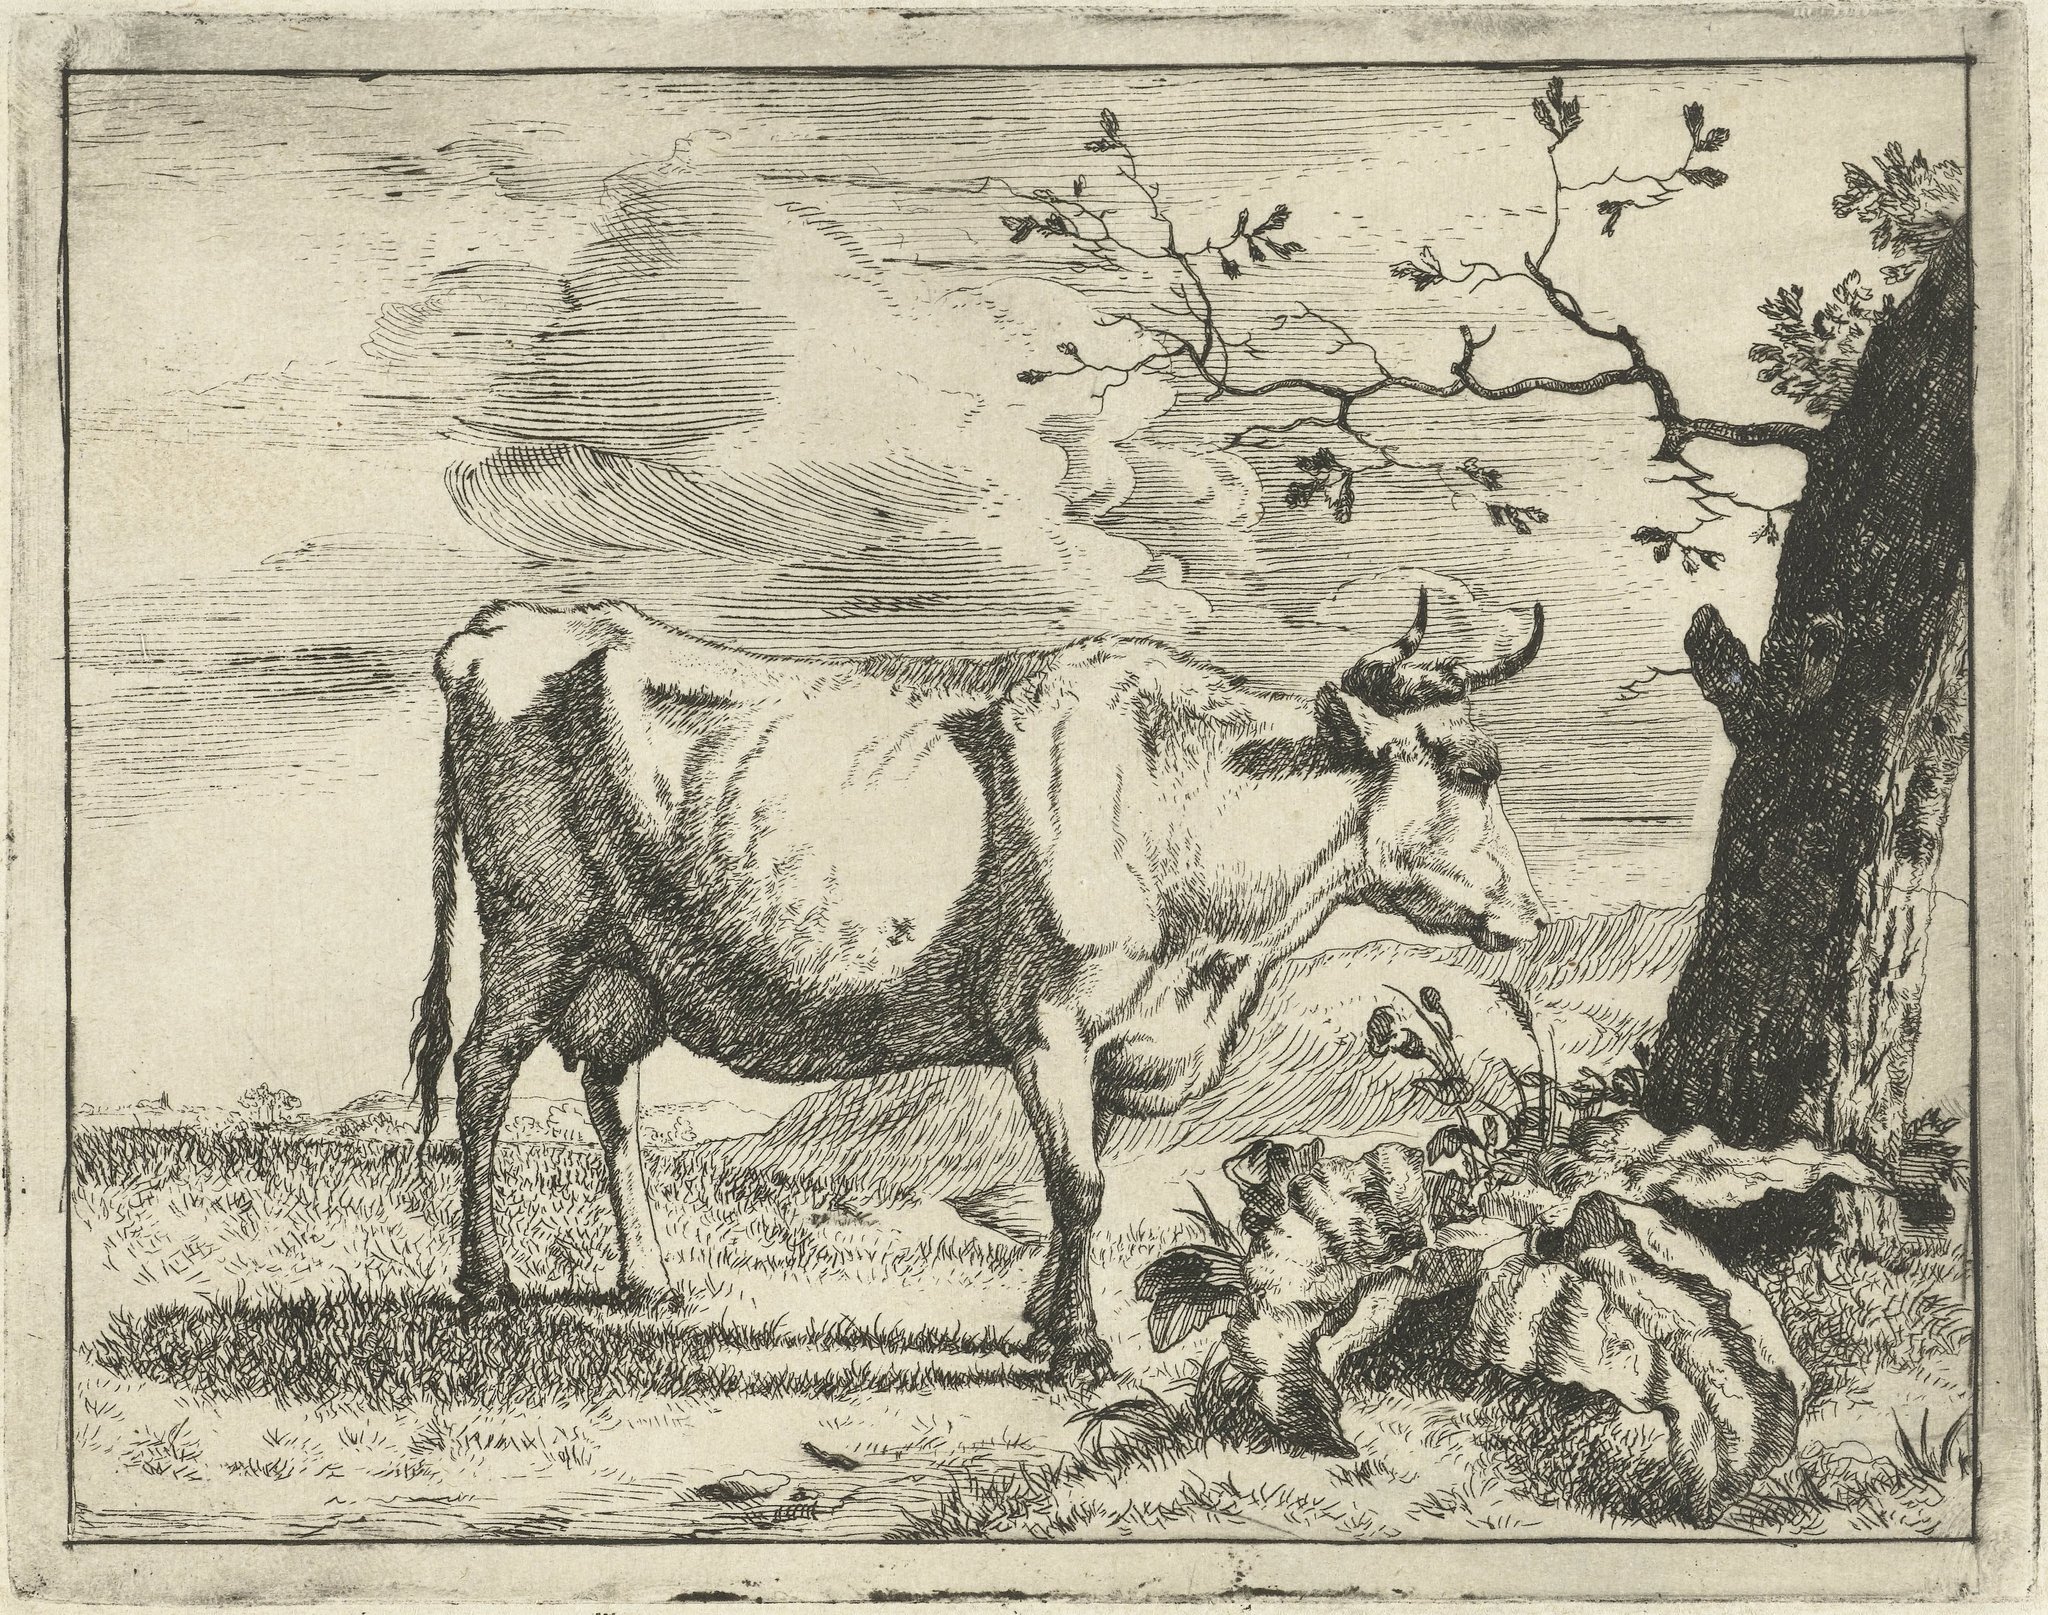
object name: print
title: Staande koe bij boom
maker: marcus de bye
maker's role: print maker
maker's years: 1639-1688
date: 1657-1677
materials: paper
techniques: etching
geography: the hague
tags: cow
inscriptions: collector's mark: Lugt 2228